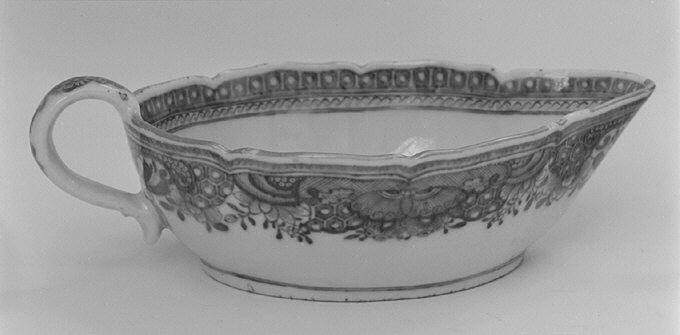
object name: sauceboat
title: Sauceboat (part of a service)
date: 1770-1785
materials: hard paste porcelain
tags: butterflies